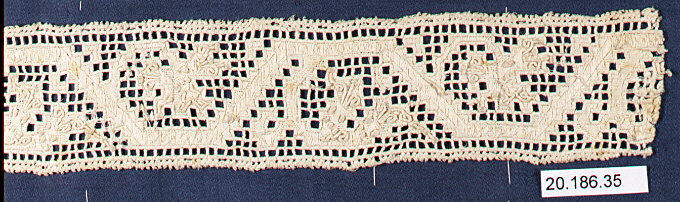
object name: band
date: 1501-1600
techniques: embroidery